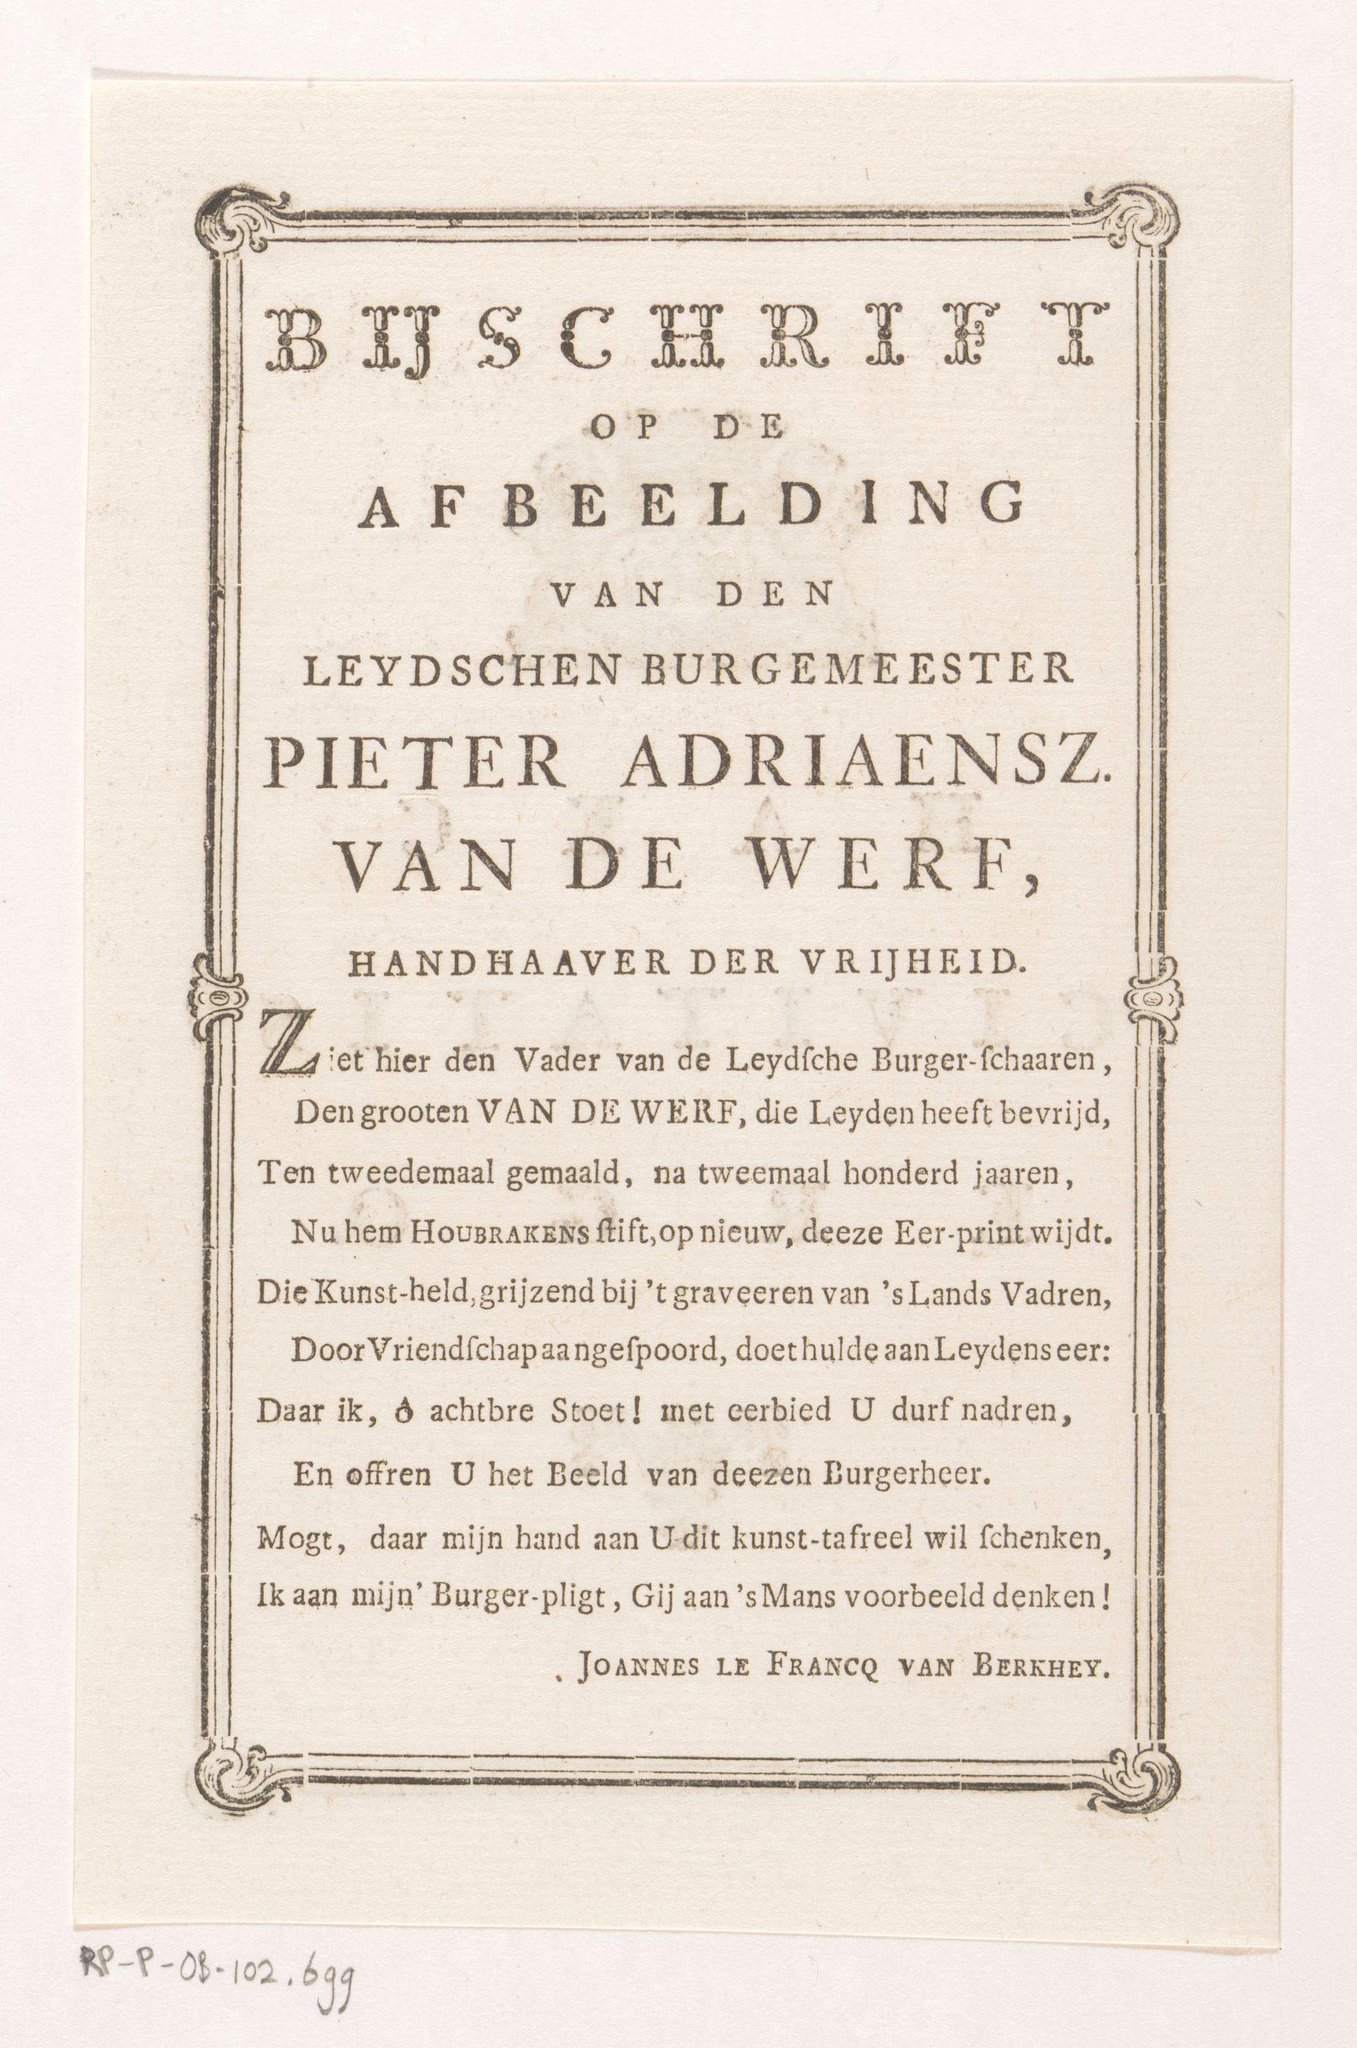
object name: text sheet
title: Bijschrift op de afbeelding van den Leydschen burgemeester Pieter Adriaensz. van de Werf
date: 1774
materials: paper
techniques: letterpress printing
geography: leiden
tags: pieter adriaansz. van der werff, beleg van leiden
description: Tekstblad gebruikt in: Joannes Le Francq van Berkhey, Het verheerlĳkt Leyden, bĳ het tweede eeuwgetĳde van deszelfs heuchlĳk ontzet. Leiden: H. Coster, Heyligert en Hoogenstraaten boekverkopers, 1774.